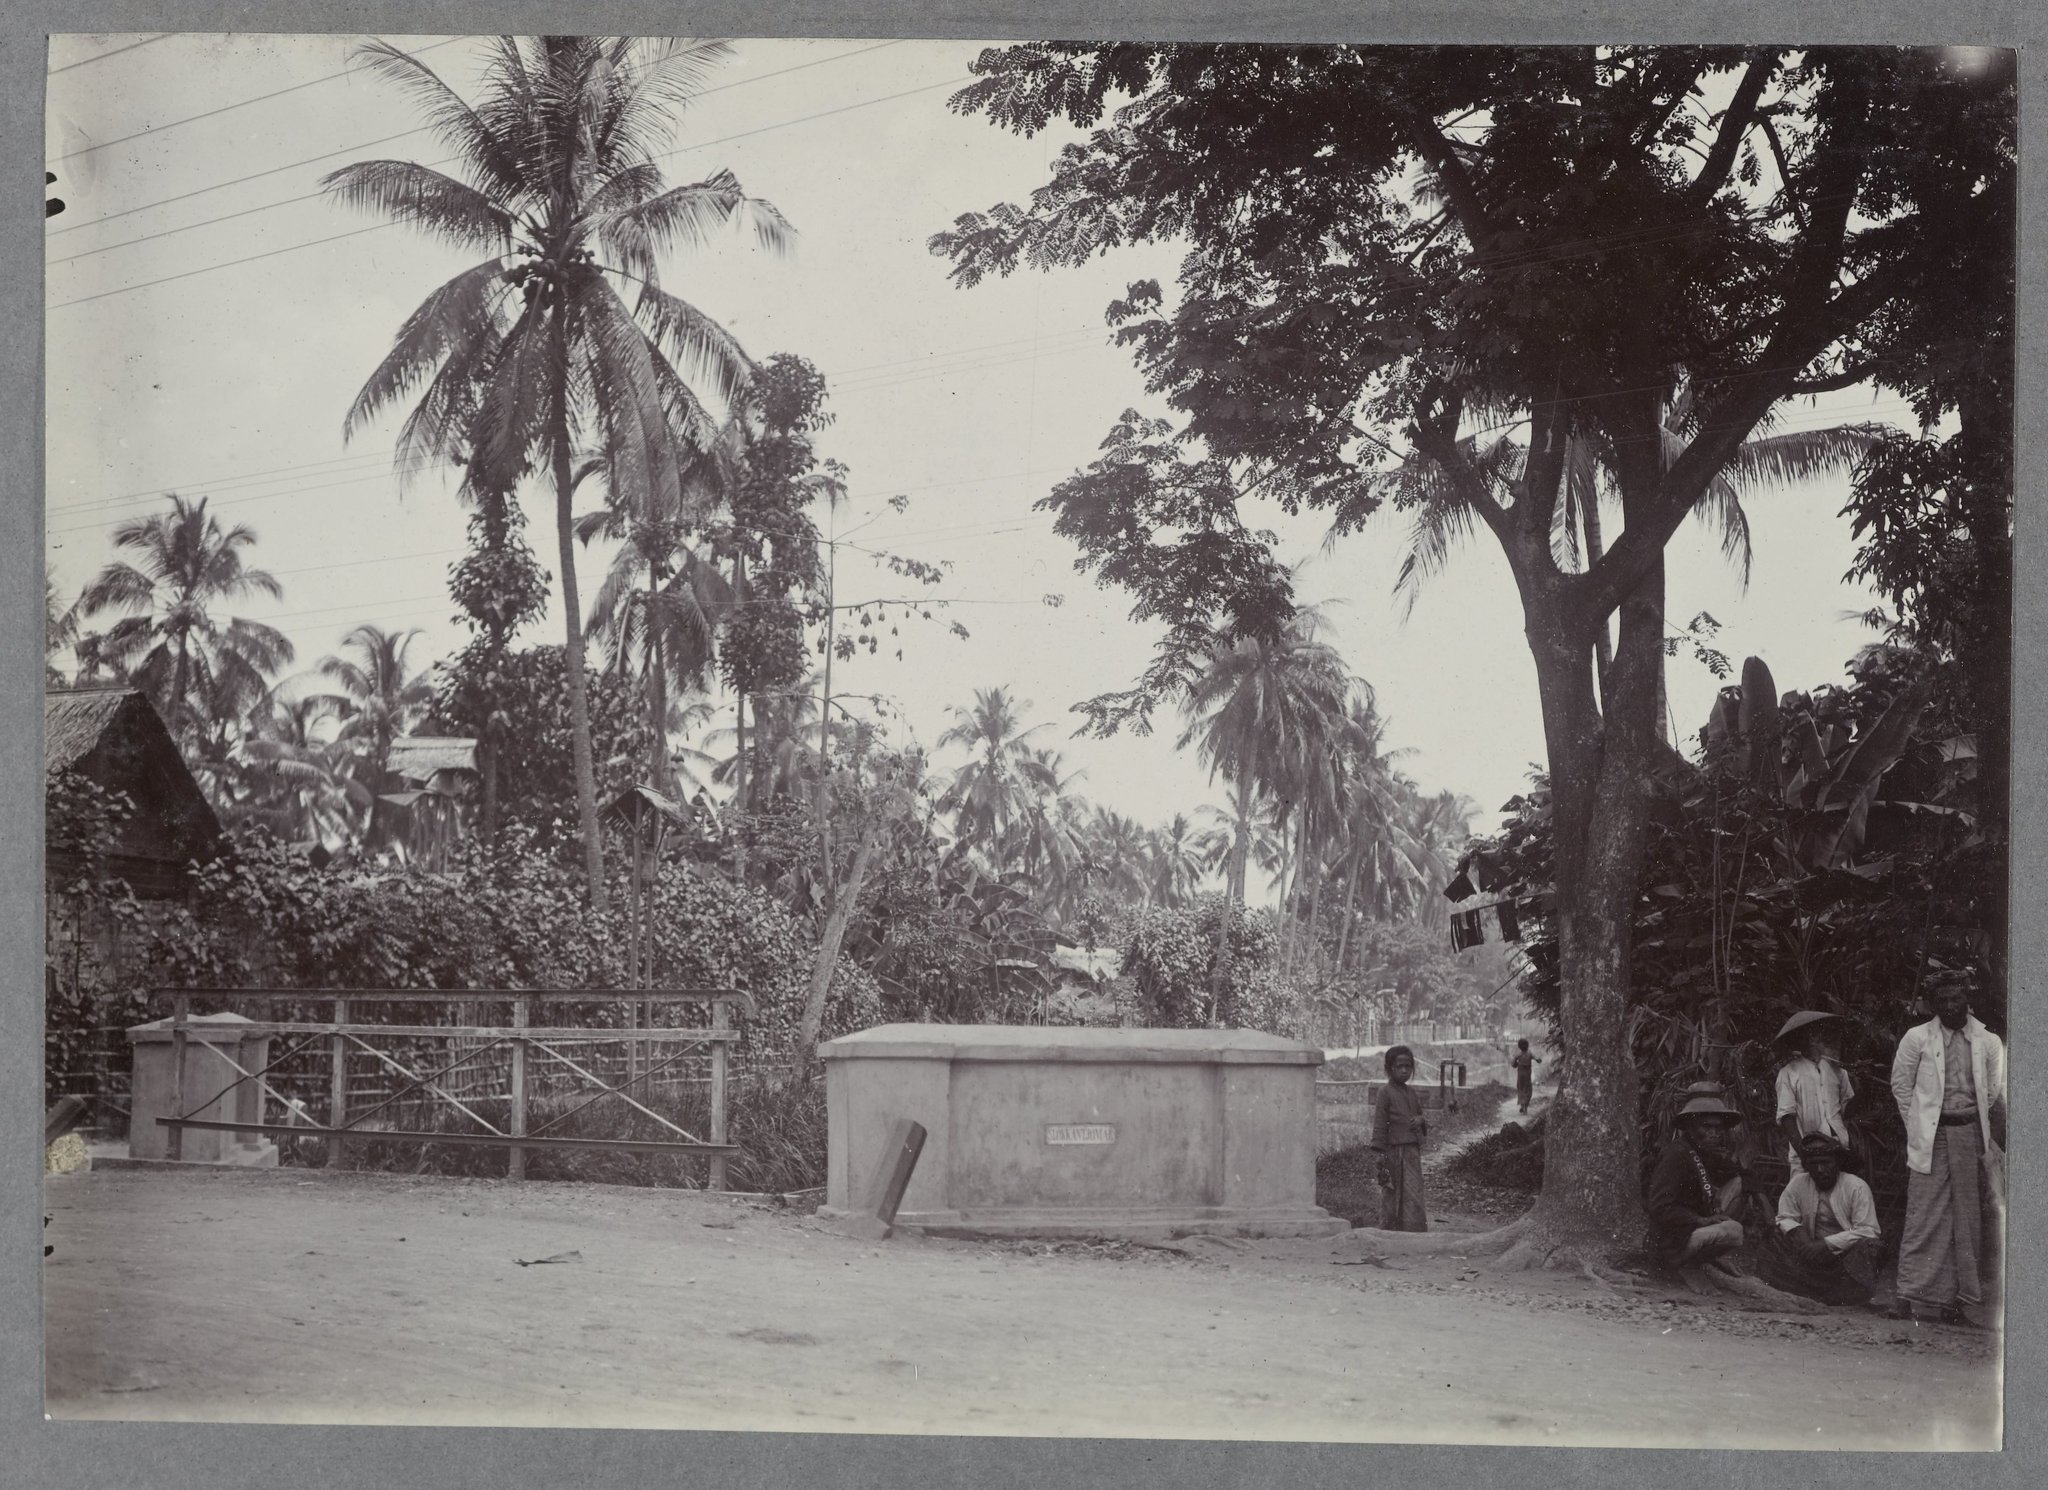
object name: photograph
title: Brug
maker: Anonymous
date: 1900-1919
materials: photographic support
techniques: collodion silver print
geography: comal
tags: colonial system, plantation, (non-fruit) products of plants or trees: sugarcane, bridge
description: Een brug met de naam Slokkantjomar, rechts bij een boom een groep Javanen. Onderdeel van het fotoalbum van de Tjomal suikerfabriek in de periode ca. 1900-1919.